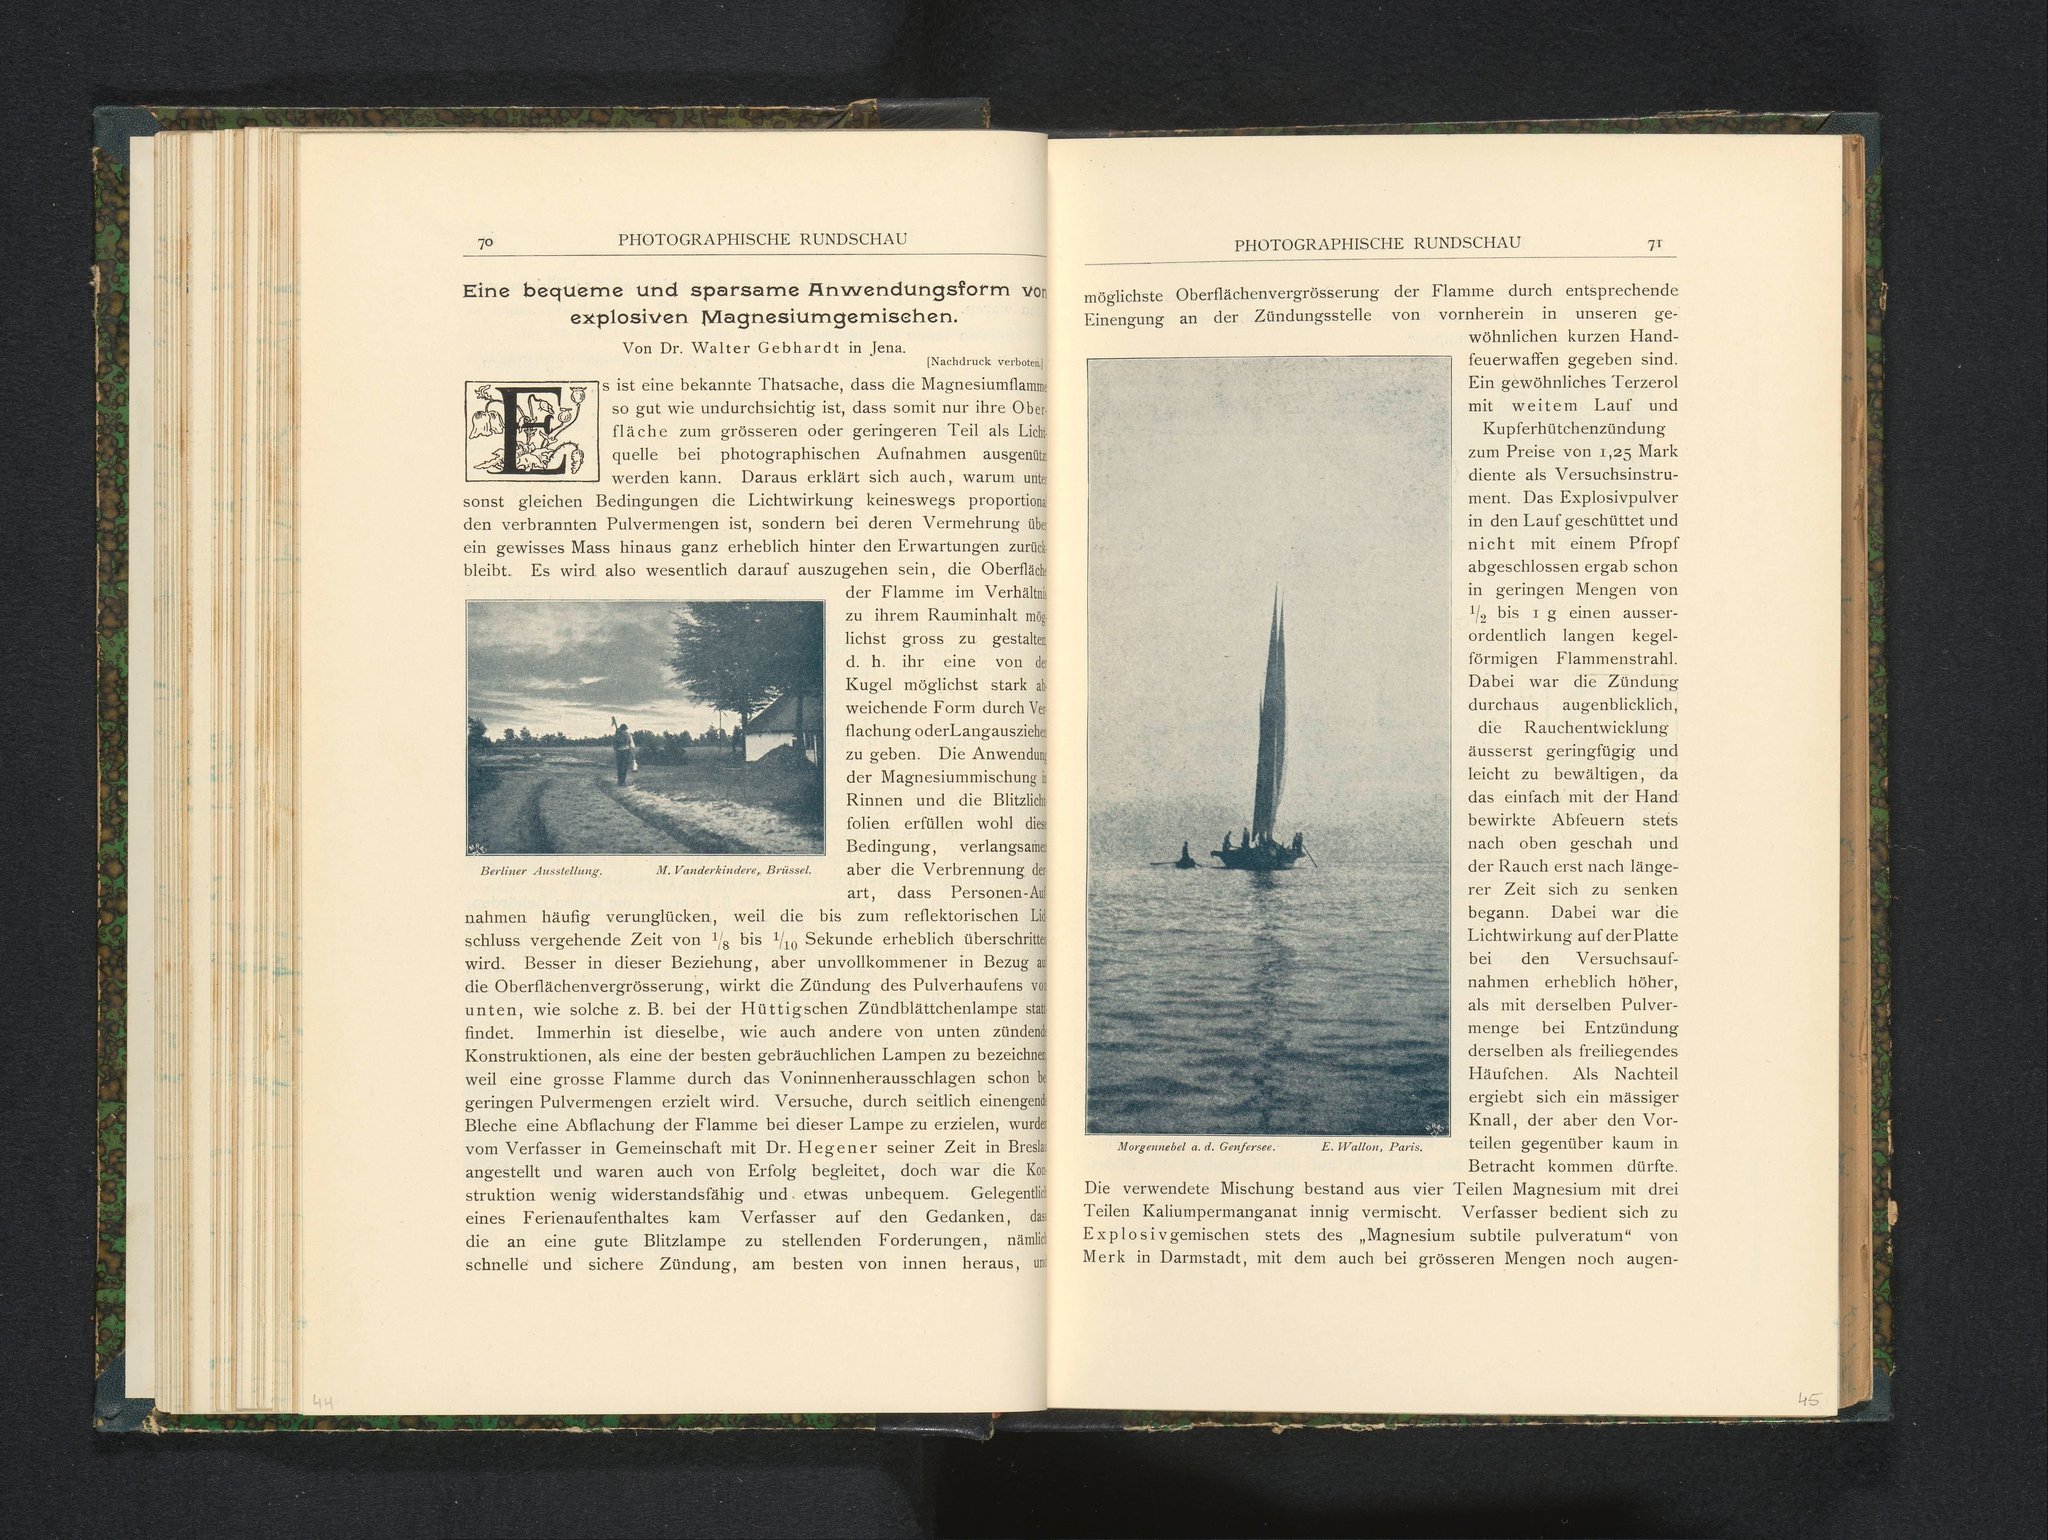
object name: photomechanical print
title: Zeilboot op het water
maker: étienne wallon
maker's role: fotograaf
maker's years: 1855-1924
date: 1894-1899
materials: paper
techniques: autotype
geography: berlin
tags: sailing-ship, sailing-boat, sea (seascape)